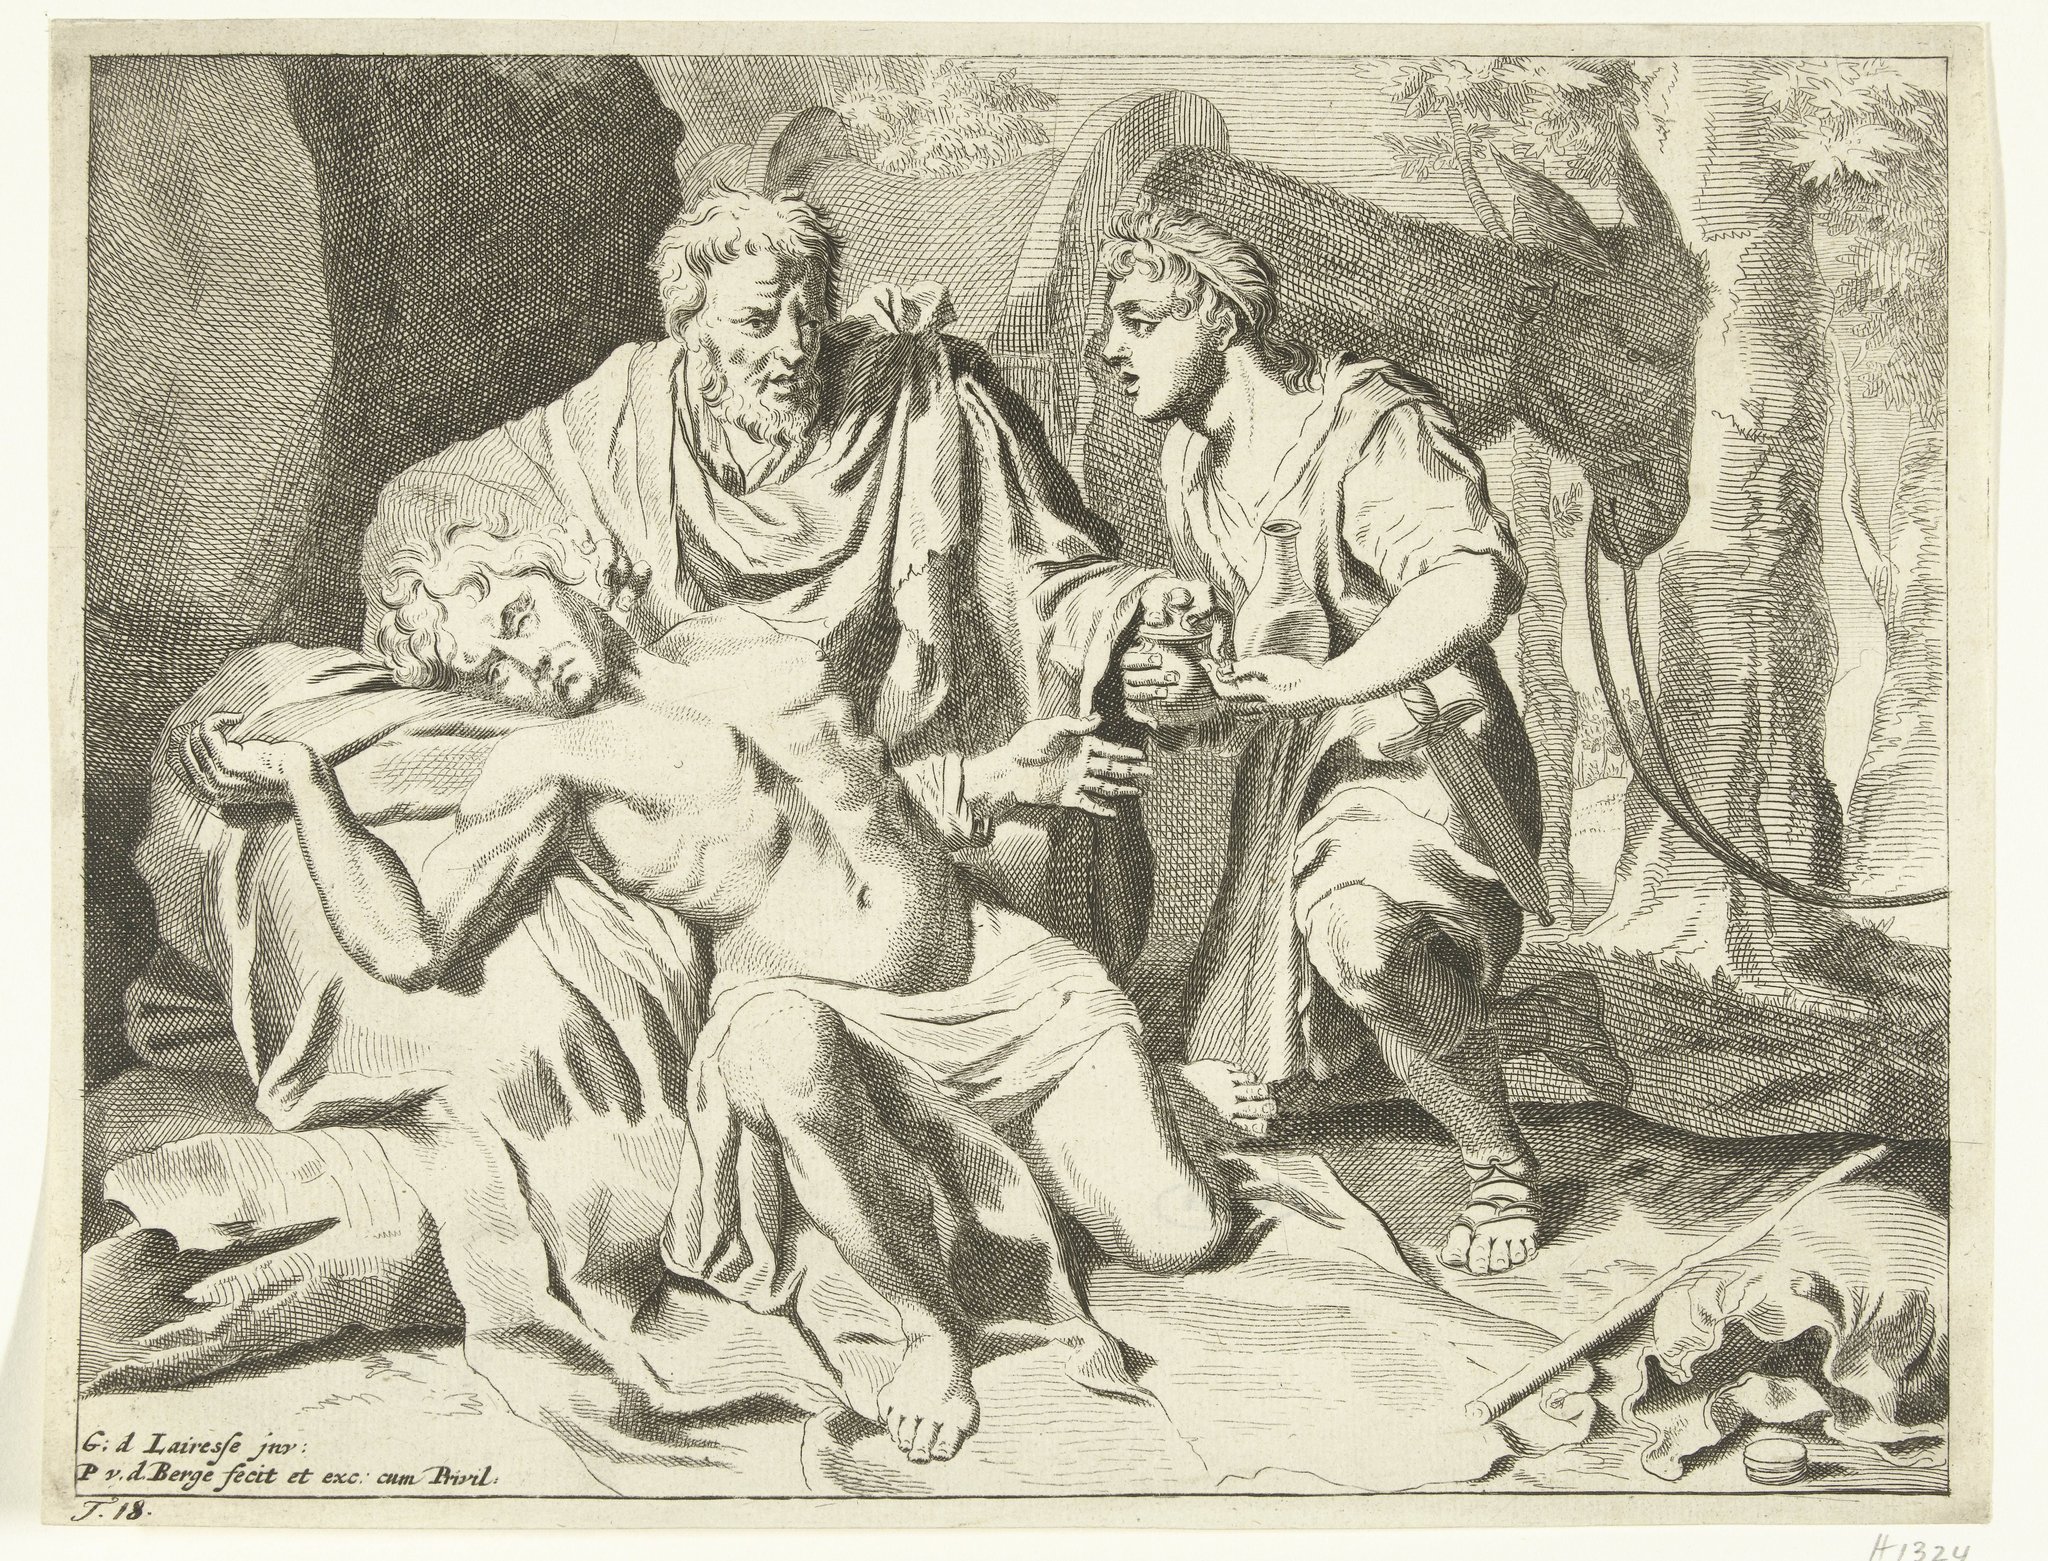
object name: print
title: De barmhartige Samaritaan helpt de gewonde reiziger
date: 1694-1737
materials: paper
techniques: engraving, etching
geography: amsterdam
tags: a samaritan tending the wounds of the traveller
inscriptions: collector's mark: Lugt 11, number: ‘T.18.’, collector's mark: Lugt 2228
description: De barmhartige Samaritaan en zijn knecht helpen de gewonde reiziger. De Samaritaan giet olie op diens wonden. Rechts op de voorgrond is nog de lege geldbuidel van de beroofde reiziger te zien.